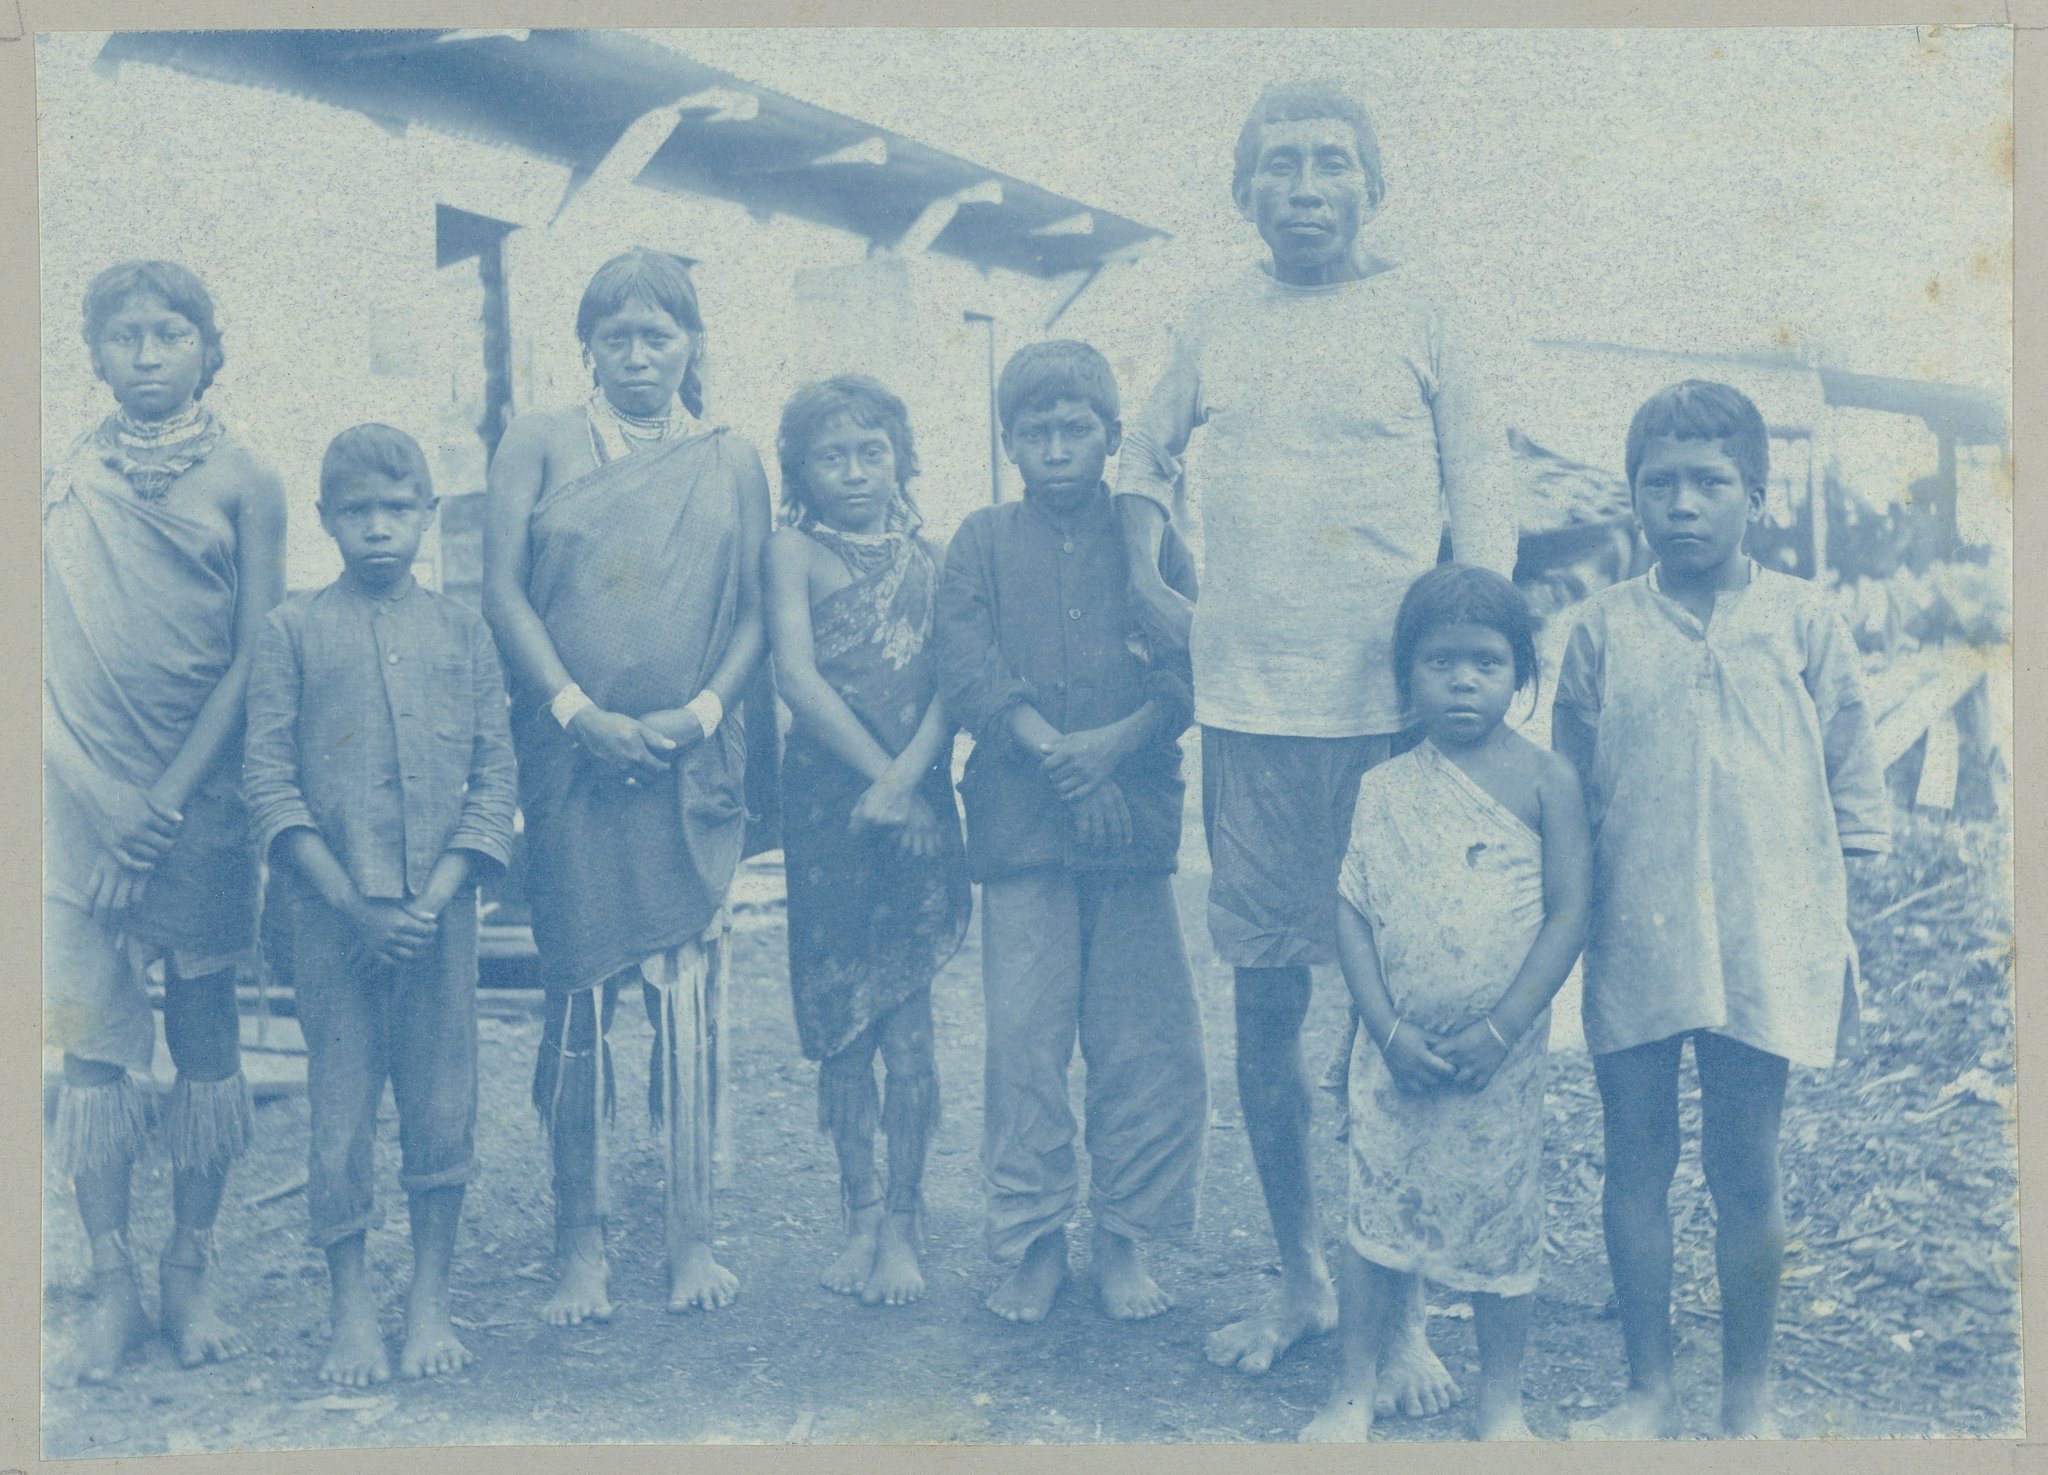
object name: photograph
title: Surinaamse Caraïben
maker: hendrik doijer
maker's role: engineer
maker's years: 1863-1925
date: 1903-1910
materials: photographic support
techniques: cyanotype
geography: suriname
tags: indigenous peoples of south america, suriname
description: Een groep Surinaamse Indiaanse Karaïben. Onderdeel van het fotoalbum Souvenir de Voyage (deel 2), over het leven van de familie Doijer in en rond de plantage Ma Retraite in Suriname in de jaren 1903-1910.